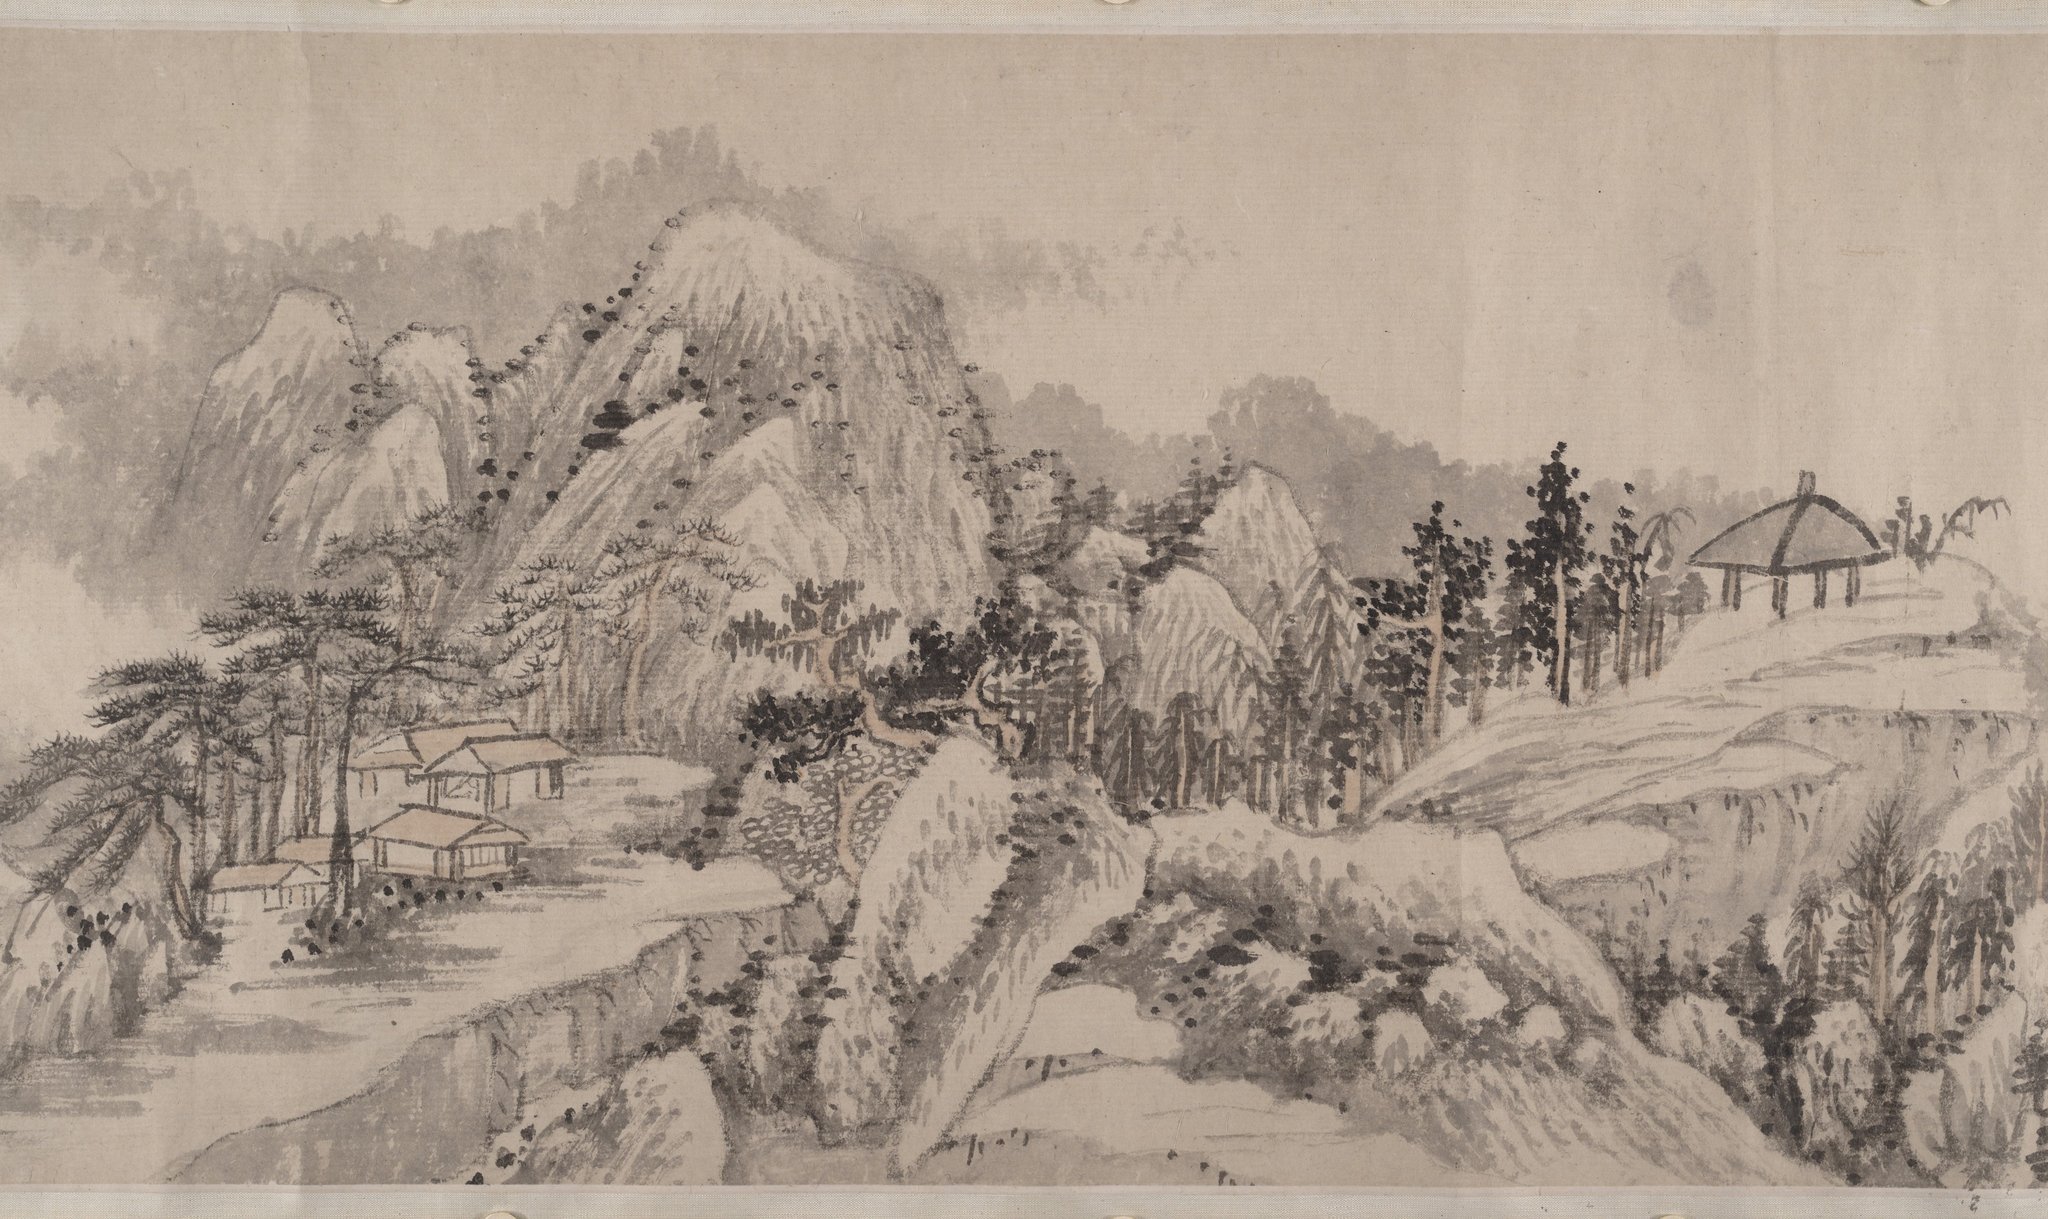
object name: handscroll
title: Remote Valleys, Sounds of Waterfalls, Deep Forests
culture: chinese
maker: liu yu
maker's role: artist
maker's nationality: chinese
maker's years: 1640-1700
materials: ink, paper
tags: landscapes